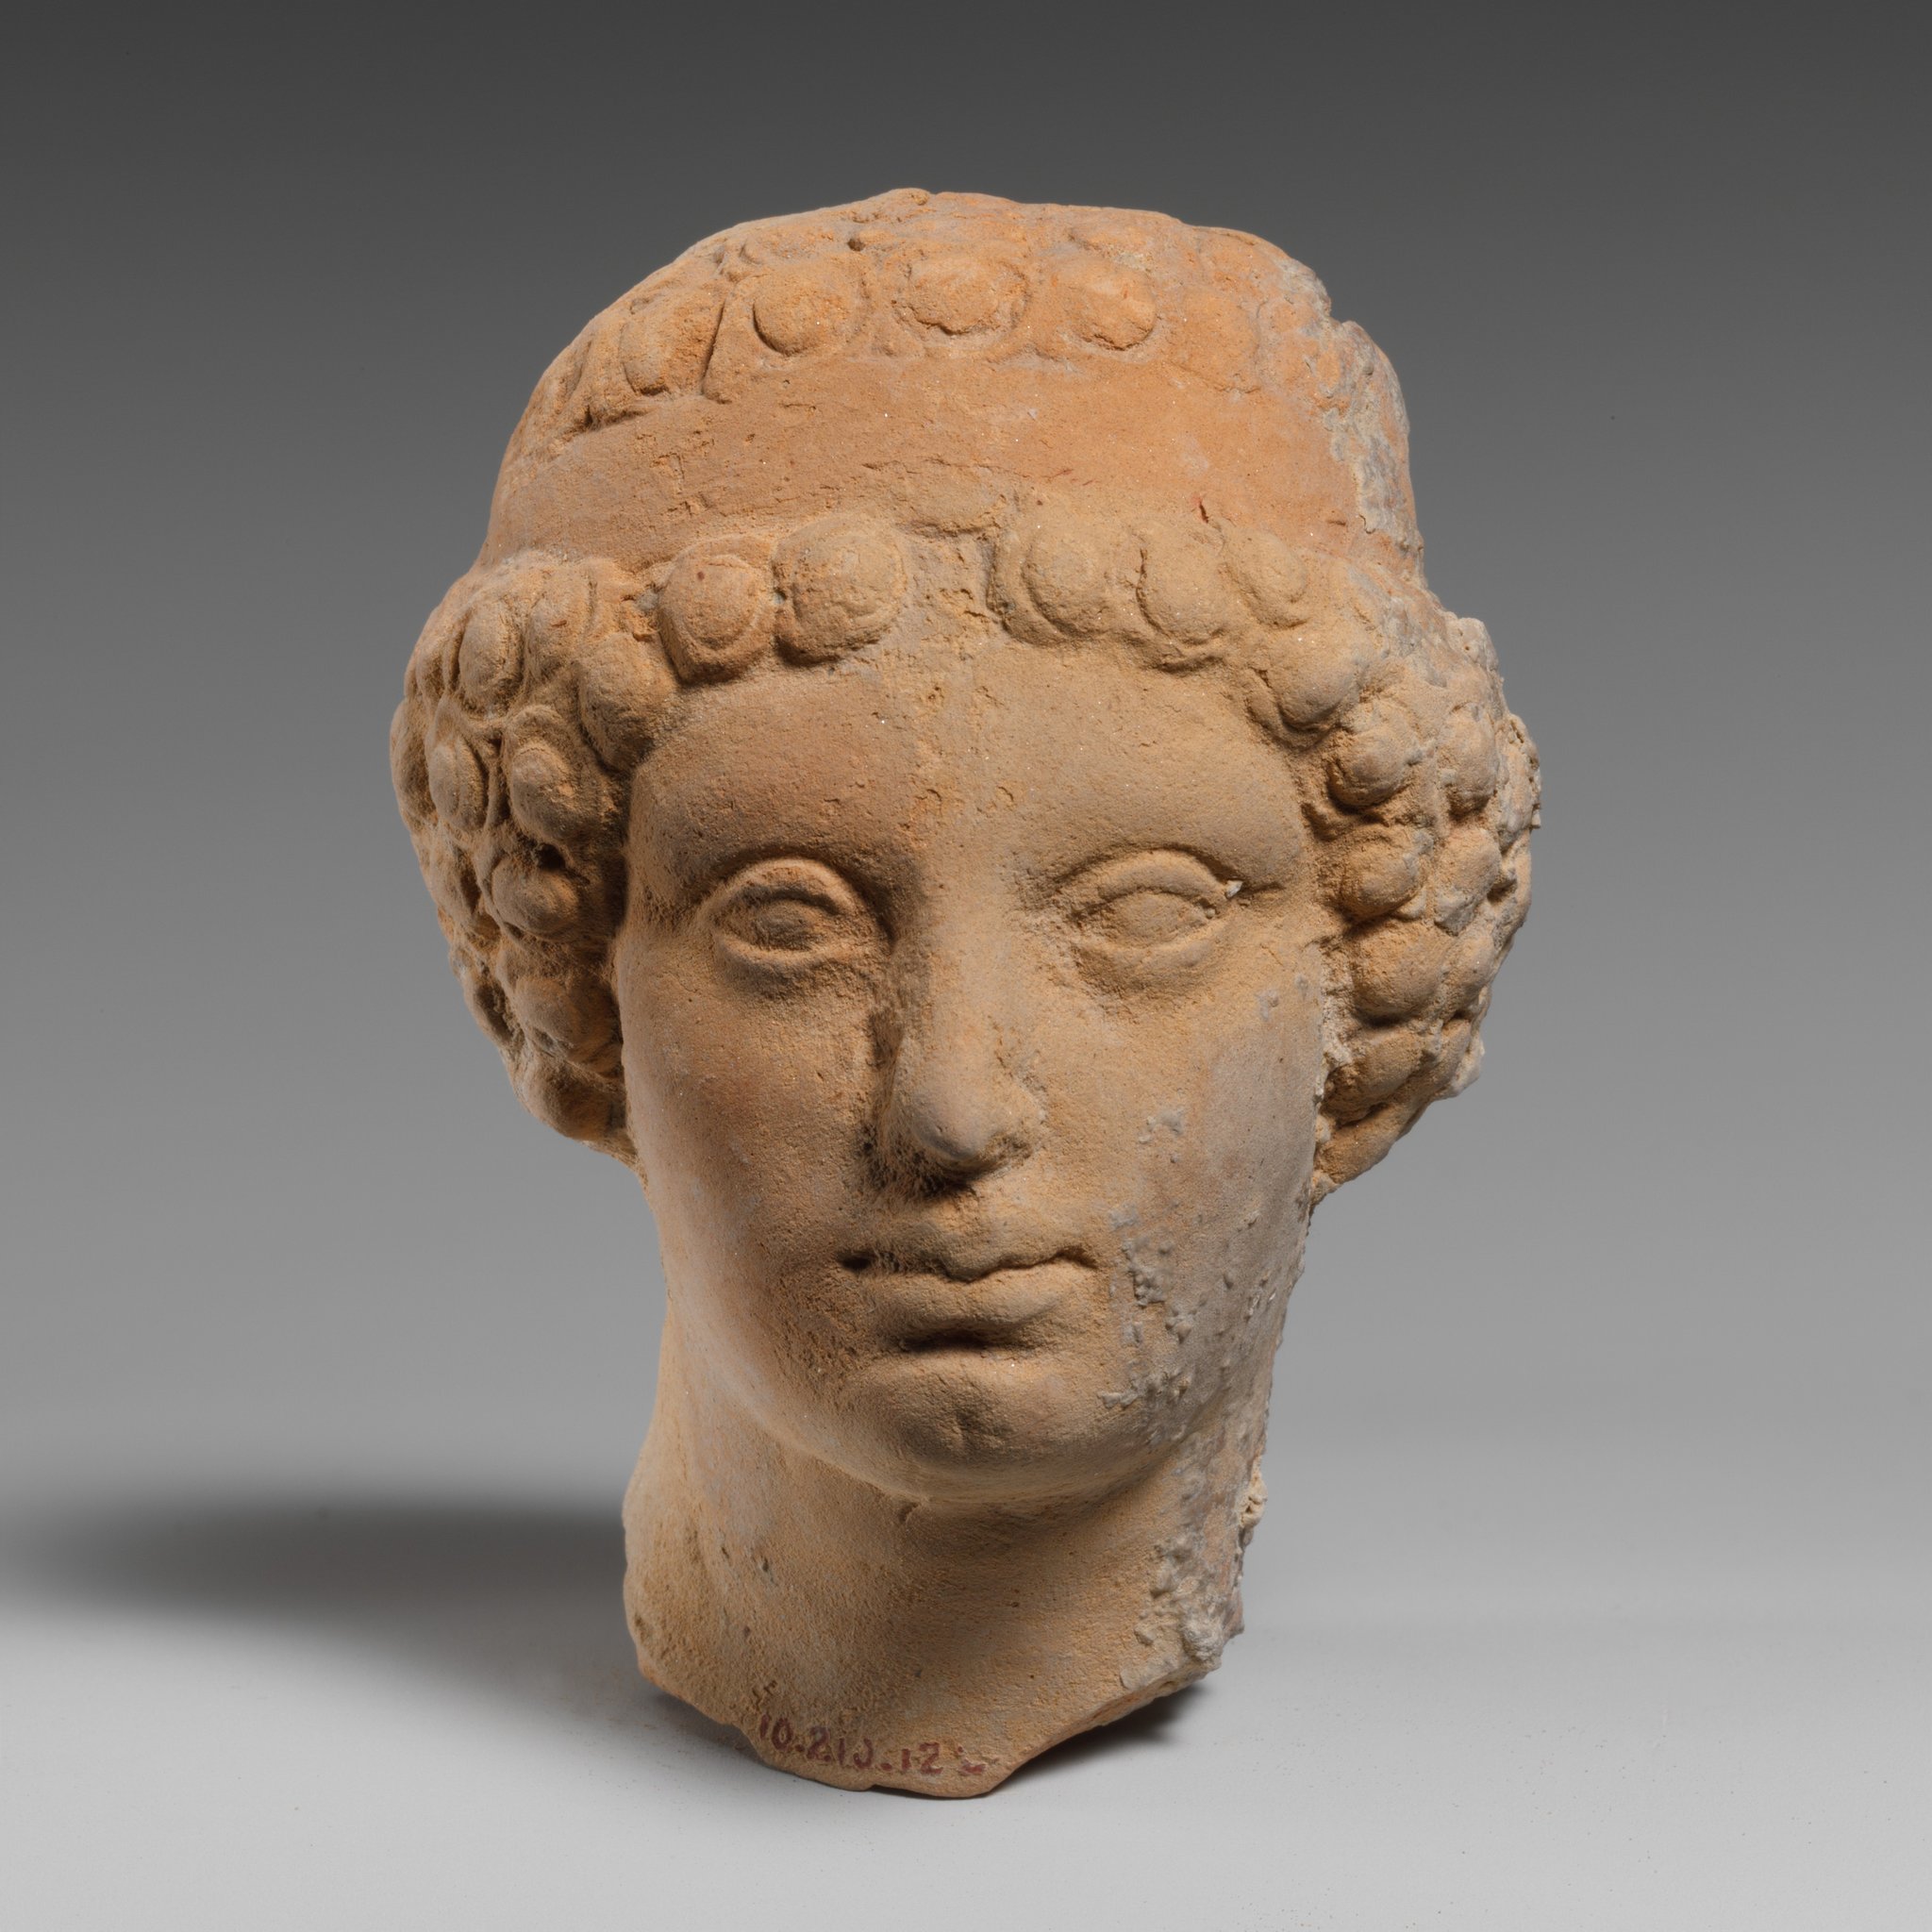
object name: head of a woman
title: Terracotta head of a woman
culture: greek, south italian, tarentine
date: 500-401 BCE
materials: terracotta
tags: heads,women